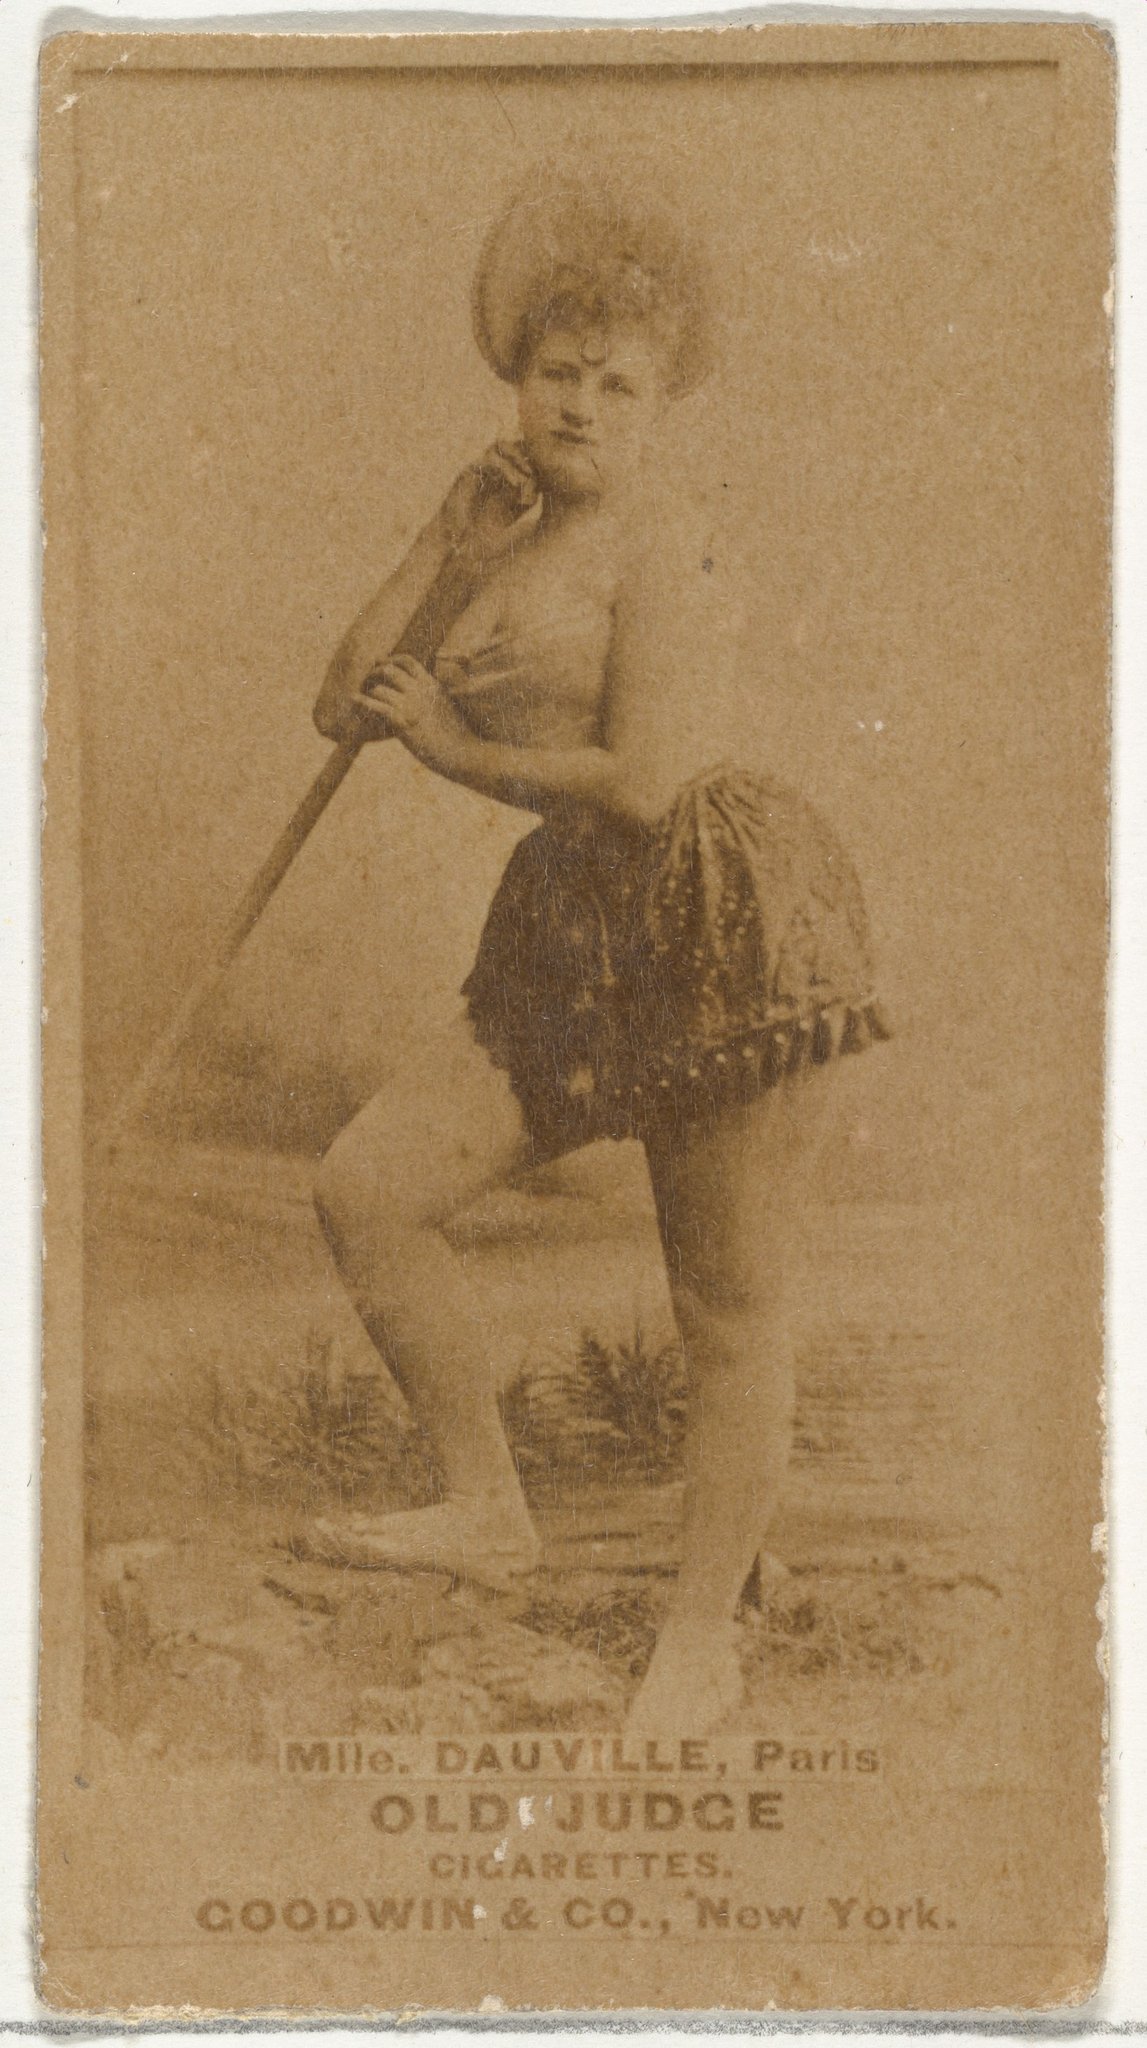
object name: photograph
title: Mlle. Dauville, Paris, from the Actors and Actresses series (N171) for Old Judge Cigarettes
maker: goodwin & company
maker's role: publisher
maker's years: 1850-1950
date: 1886-1890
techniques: albumen silver print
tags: portraits,women,actresses